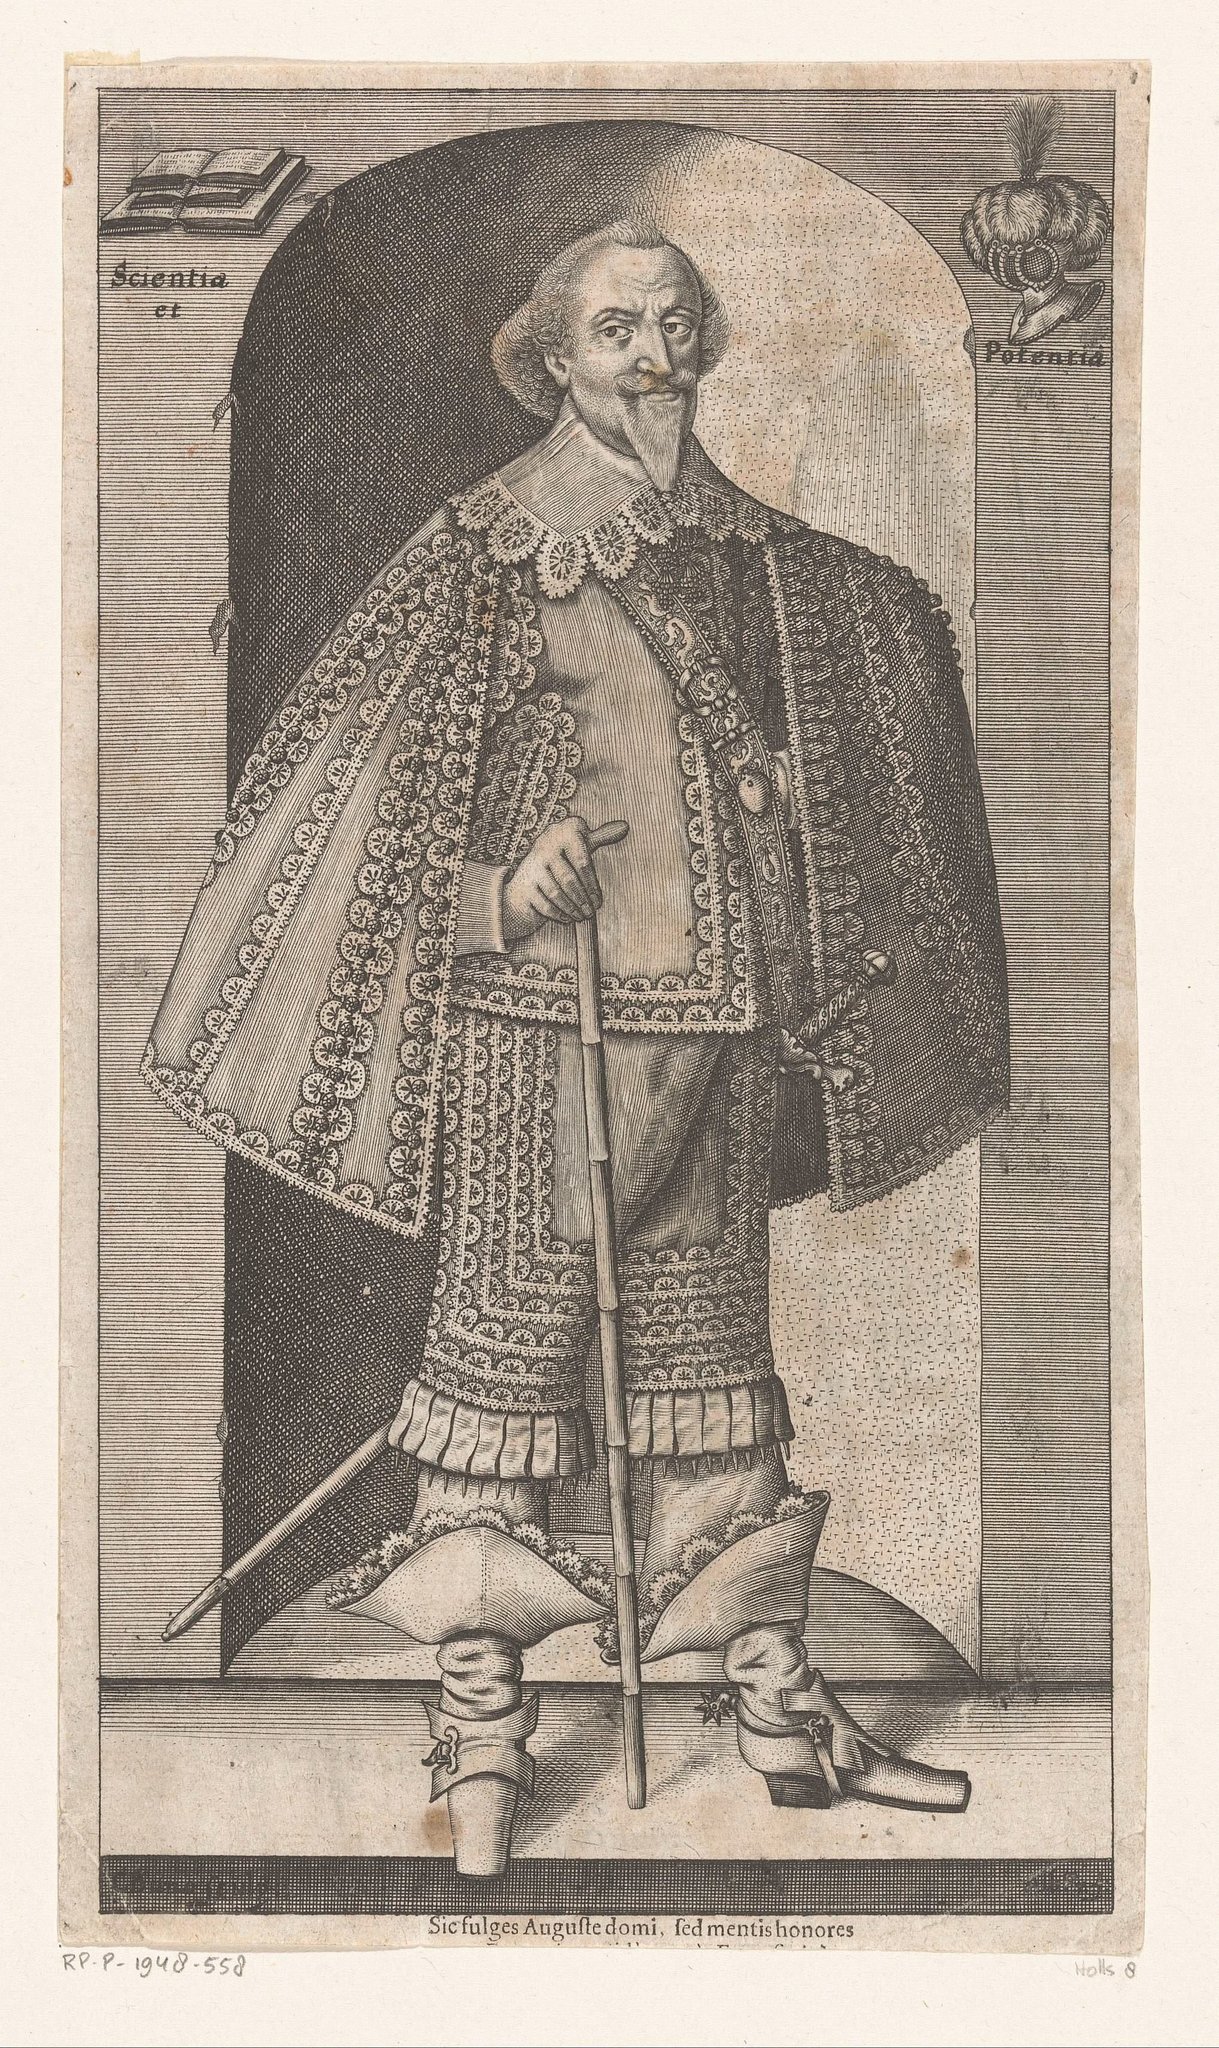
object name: book illustration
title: Portret van August II von Braunschweig-Lüneburg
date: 1650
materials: paper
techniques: engraving, letterpress printing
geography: wolfenbüttel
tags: august von braunschweig-lüneburg (hertog van braunschweig-wolfenbüttel), walking-stick, staff, historical persons, hacking and thrusting weapons: sword, spur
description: Waarschijnlijk afkomstig uit: Gosky, Martin. Arbustum seu arboretum (...). Wolfenbüttel: Johann en Heinrich Stern, 1650.